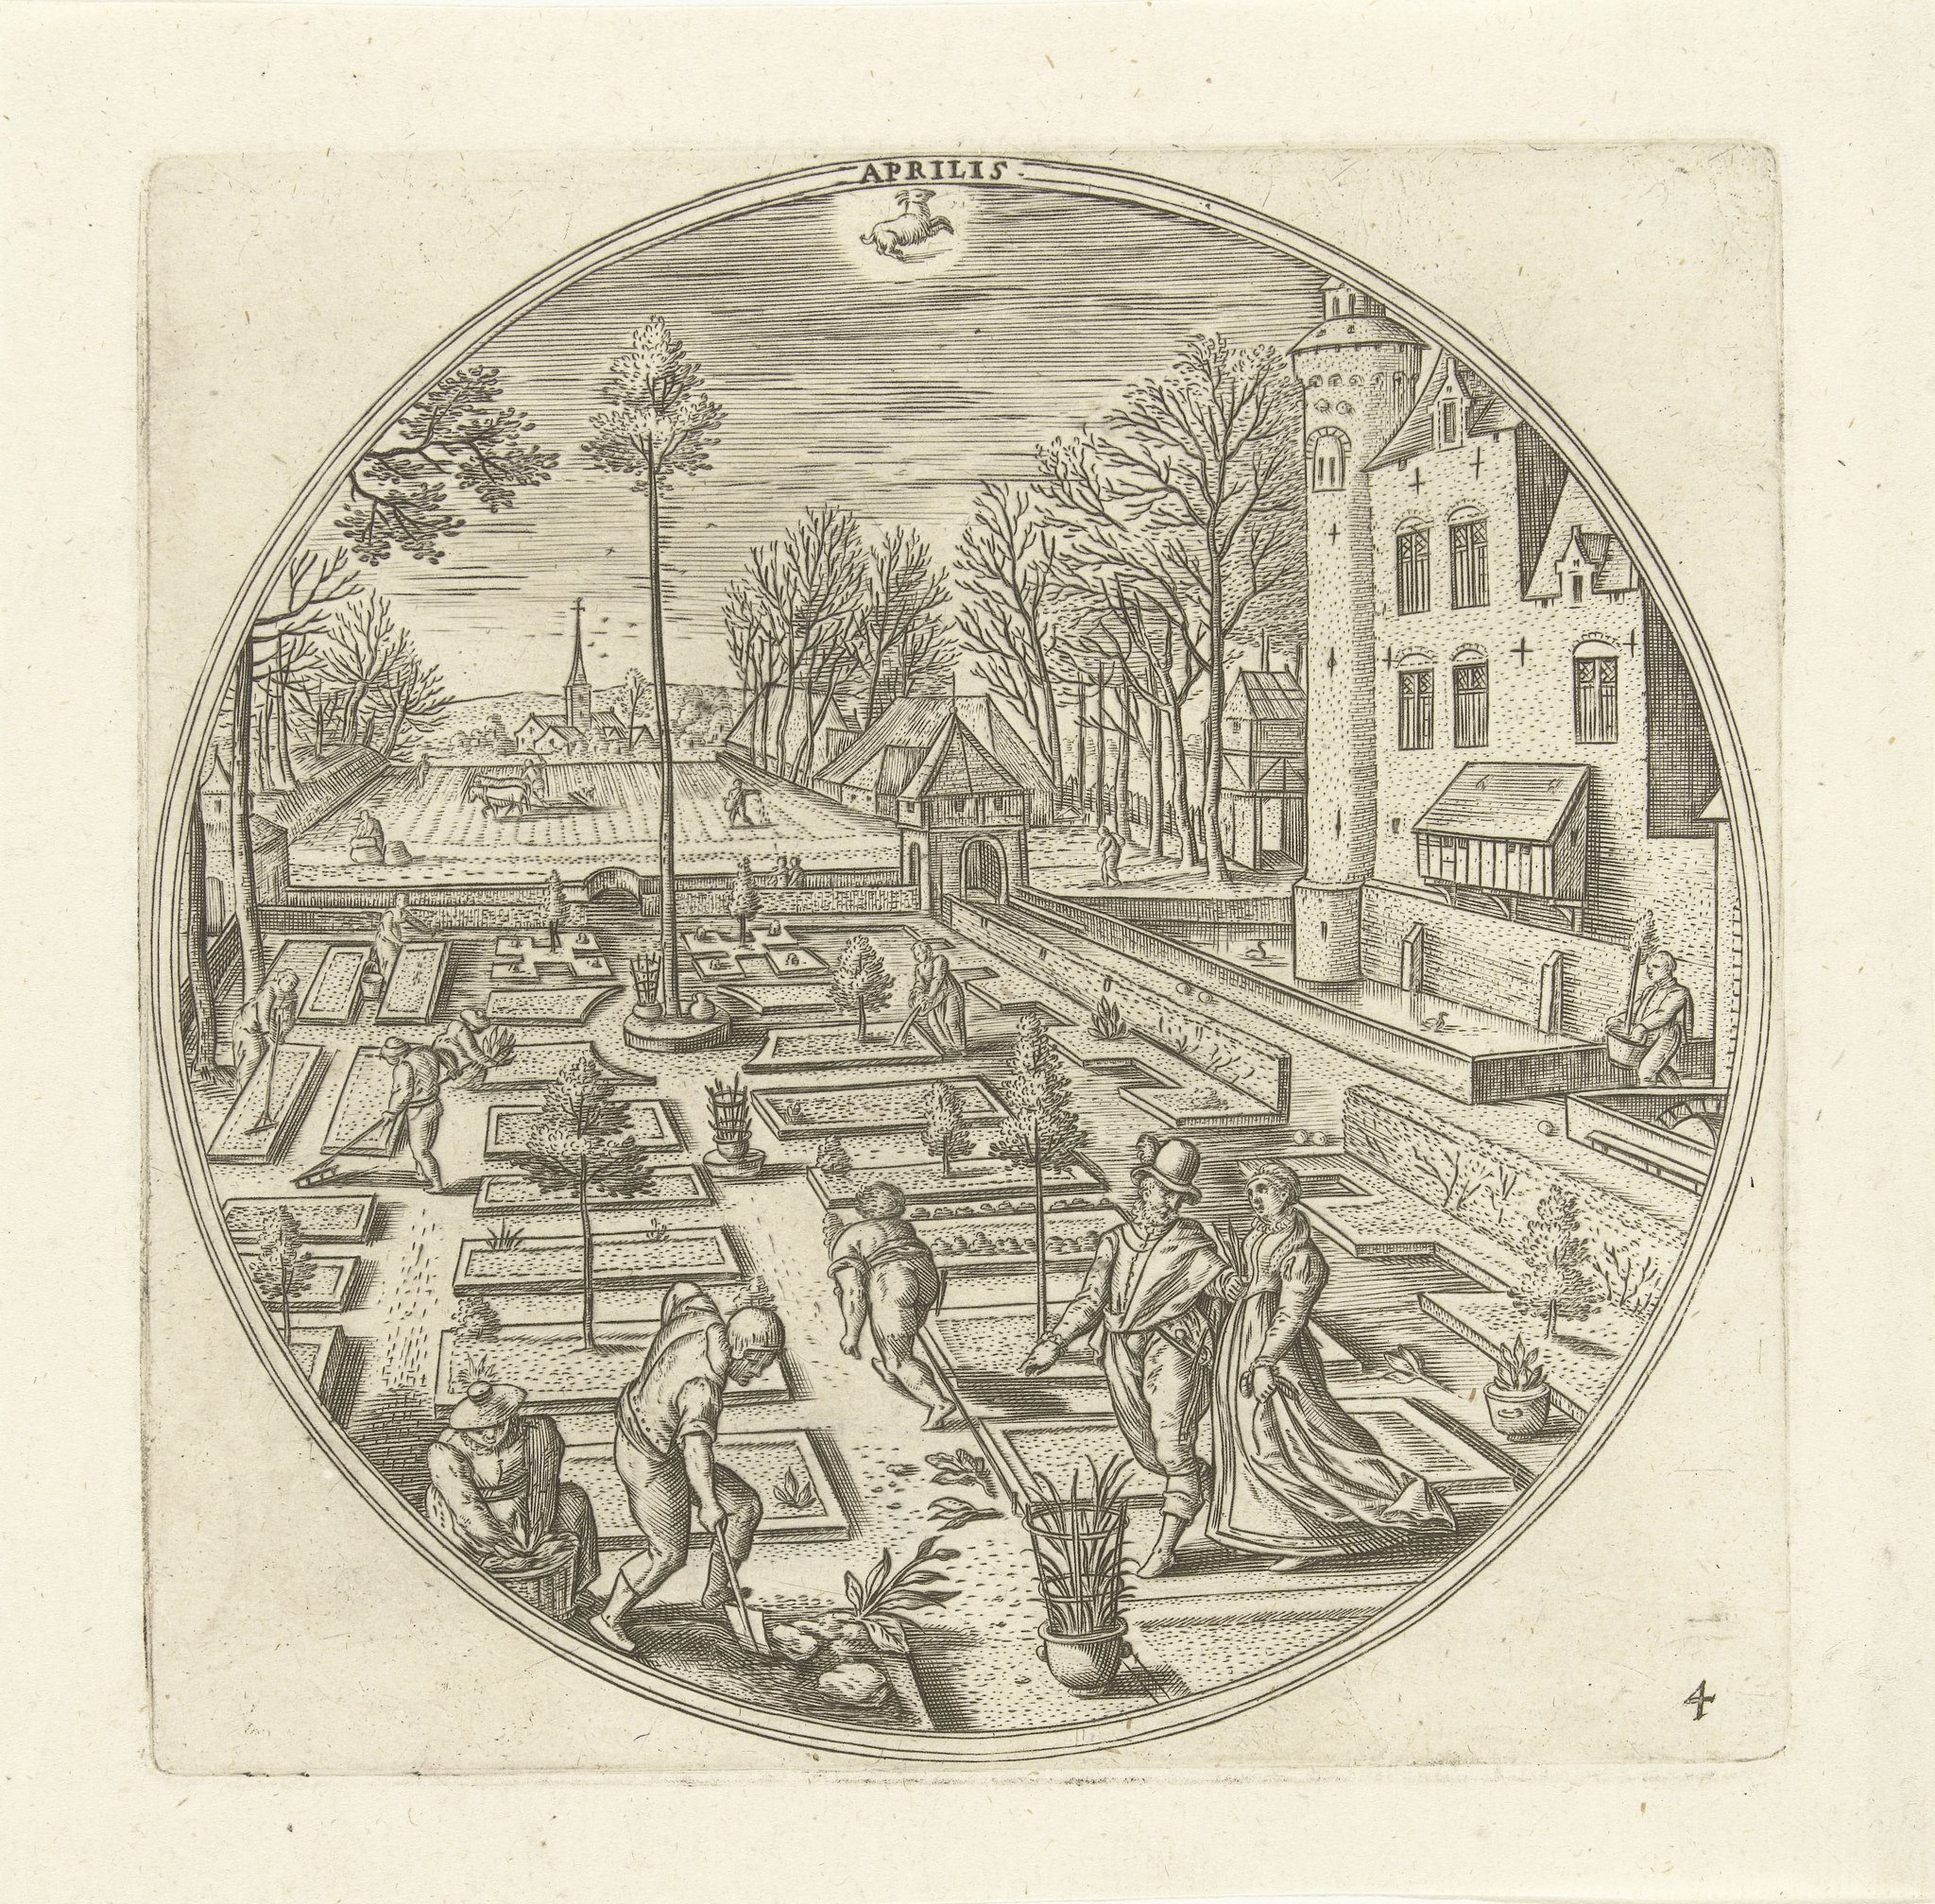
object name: print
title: De twaalf maanden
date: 1578-1582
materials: paper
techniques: engraving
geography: antwerp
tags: sowing, april and its 'labours' (+ with zodiacal signs), ploughing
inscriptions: collector's mark: Lugt 2228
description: Ronde lijst met een lentelandschap met voorjaarstaferelen. April is de grasmaand. Op de voorgrond wordt gespit en gezaaid. Op de achtergrond wordt een veld omgeploegd. Middenboven het sterrenbeeld Stier. De prent is deel van een twaalfdelige serie over de twaalf maanden.